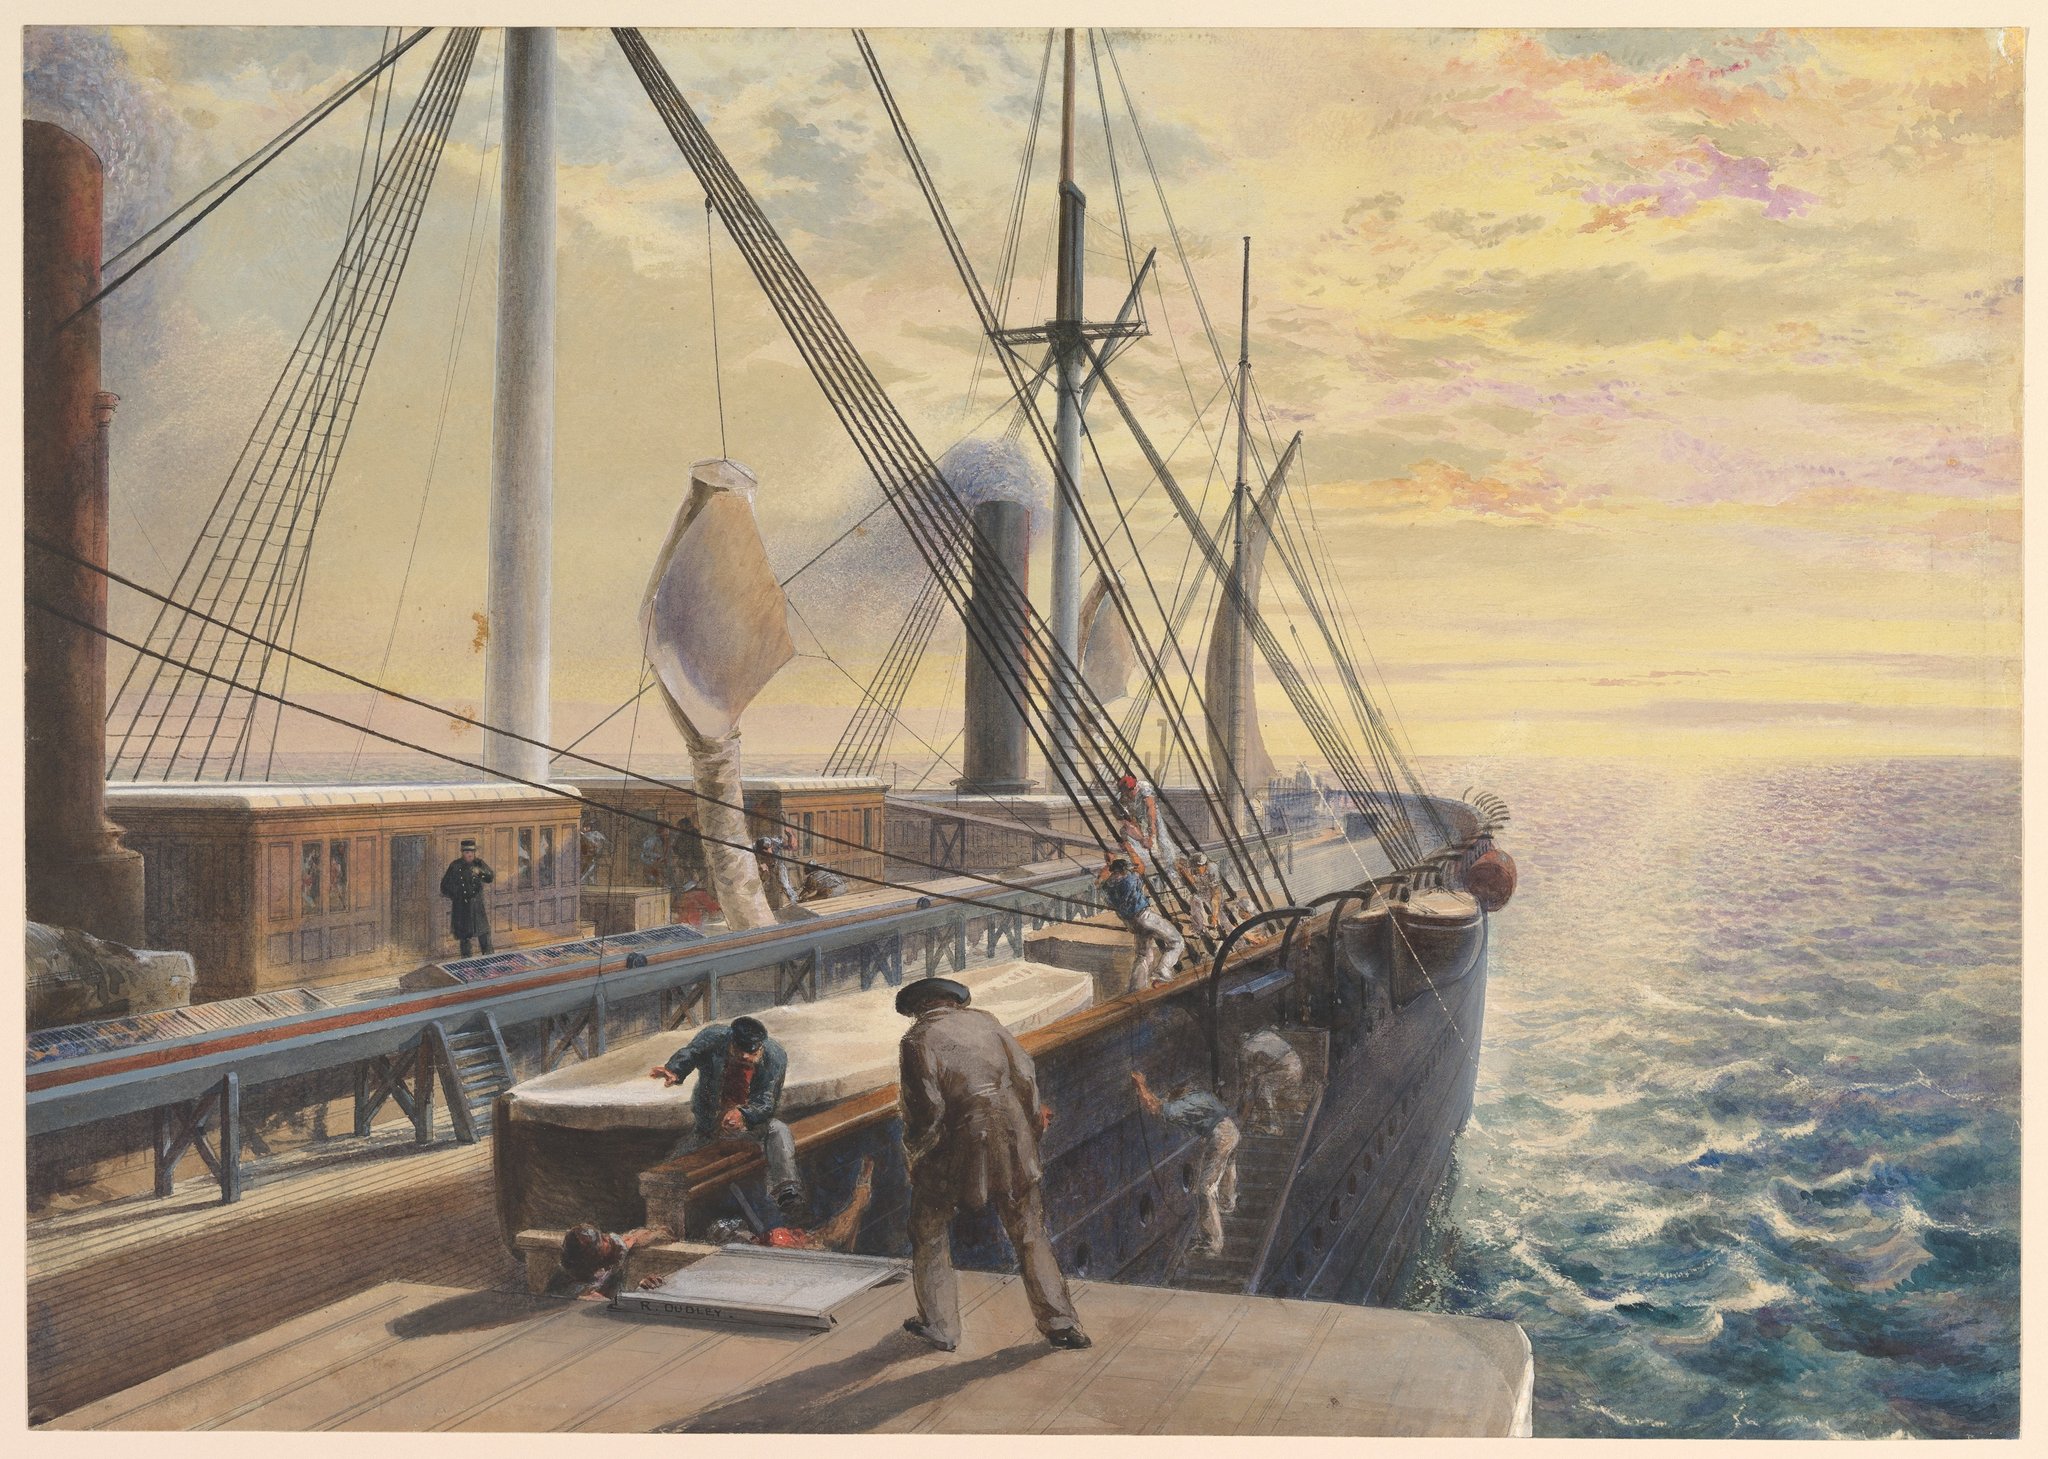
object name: drawing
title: View, Looking Aft, from the Port Paddle Box of the Great Eastern, Showing the Trough for the Cable, etc.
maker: robert charles dudley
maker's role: artist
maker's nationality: british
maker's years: 1826-1909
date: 1865-1866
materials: gouache, graphite, watercolor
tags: men,ships,transatlantic cable